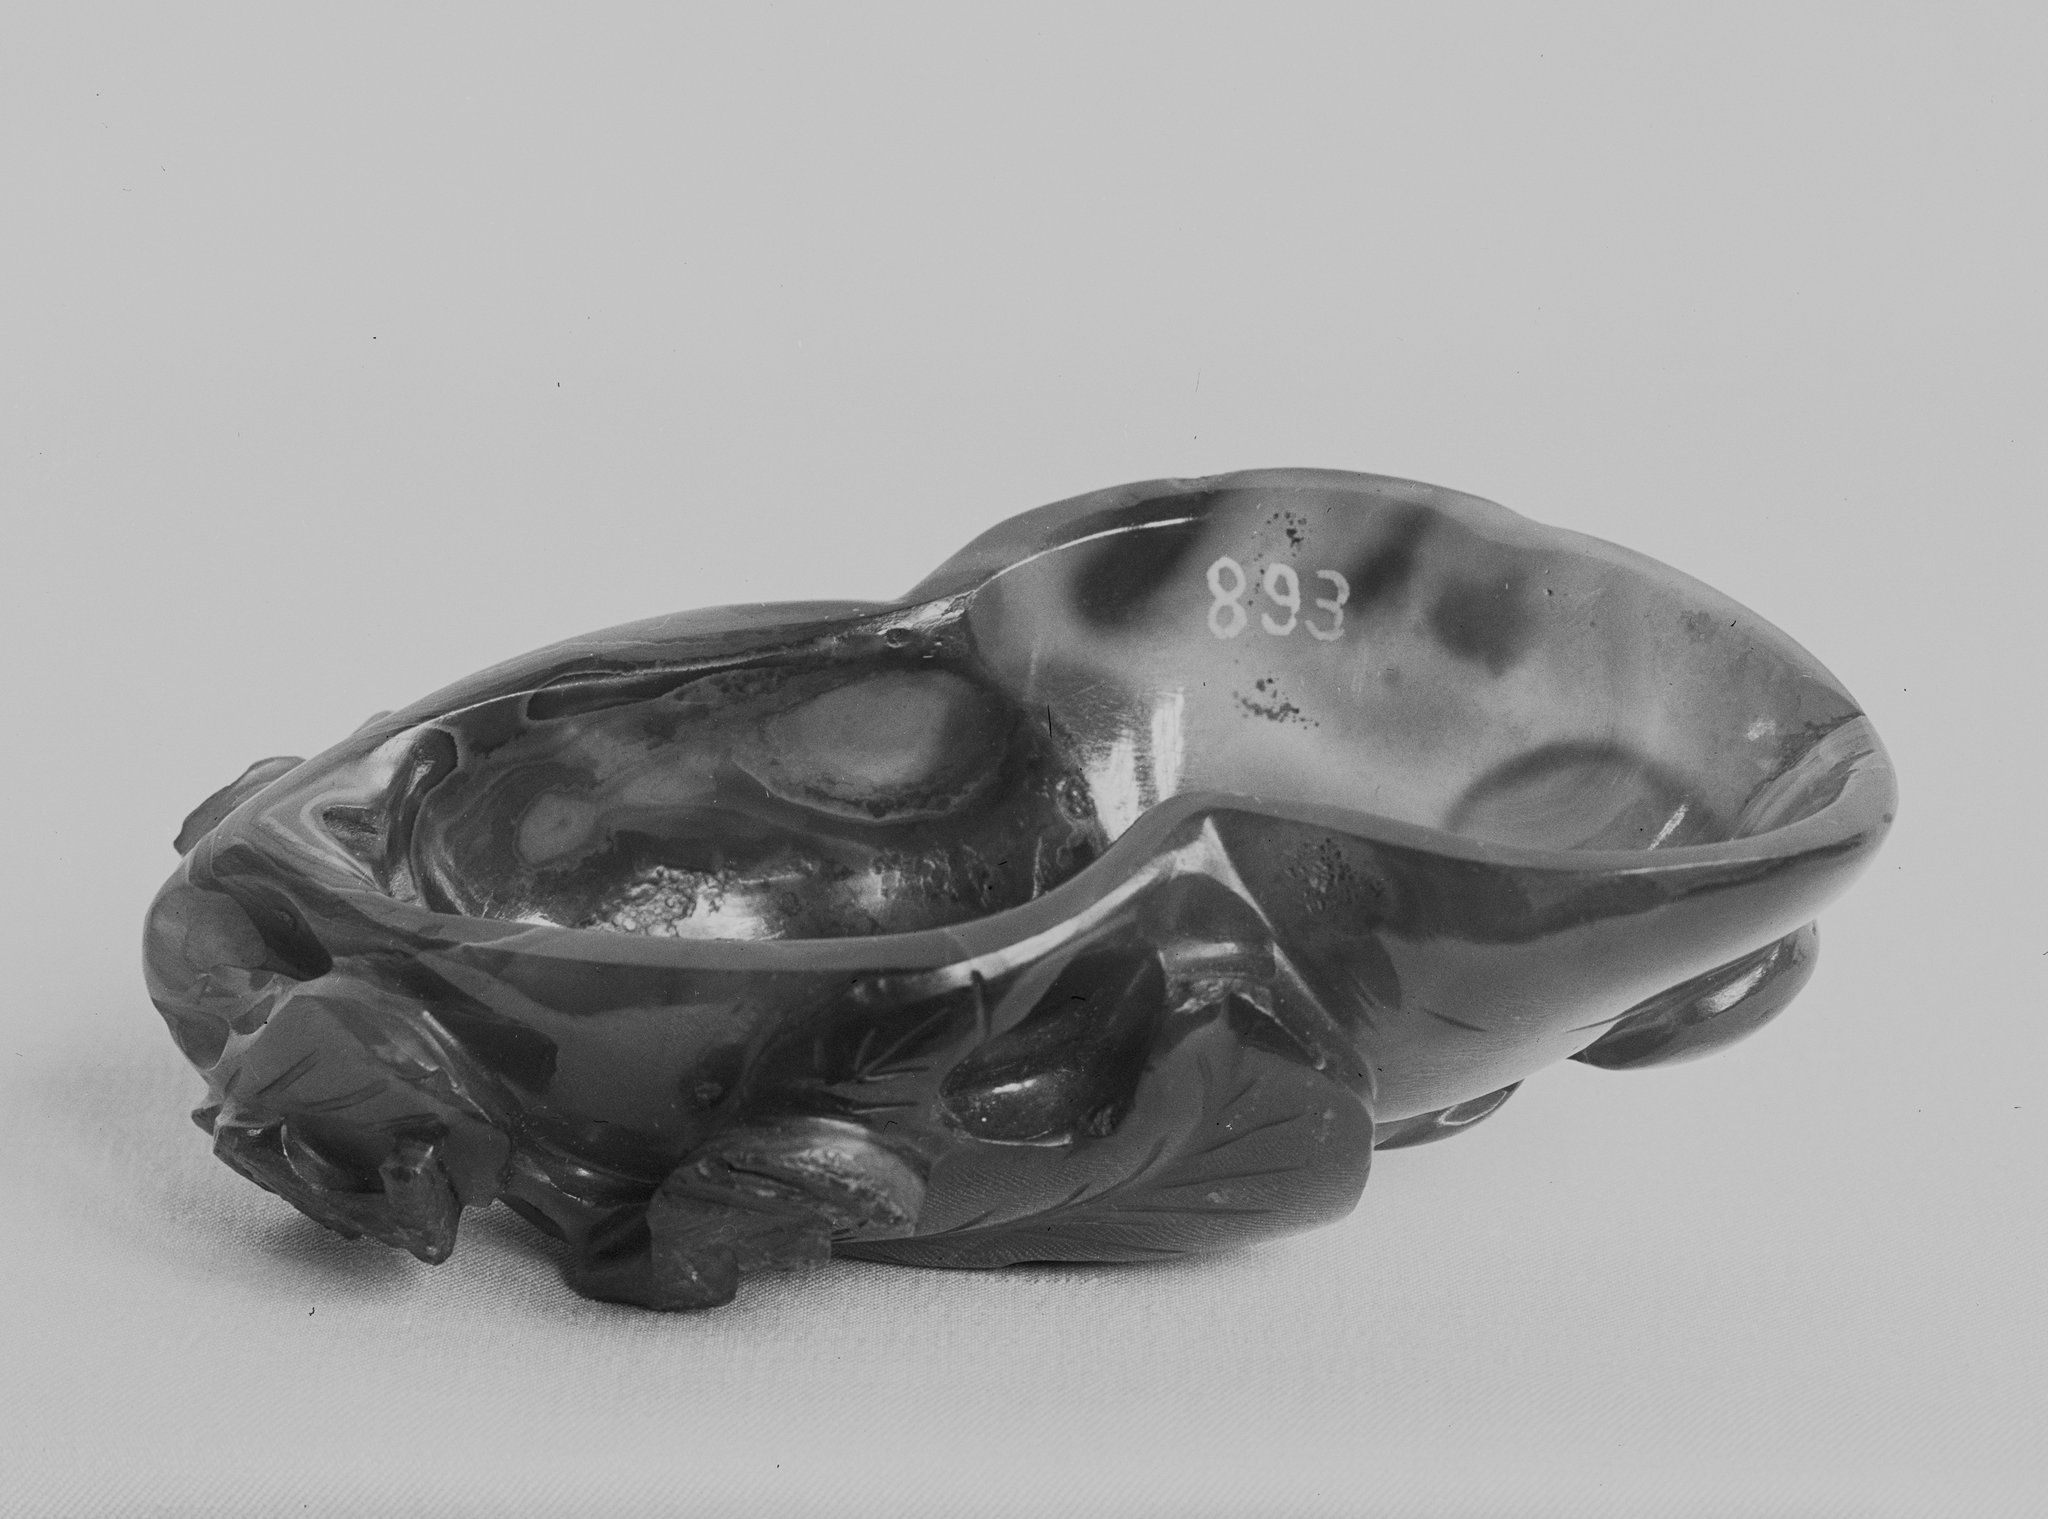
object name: dish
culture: chinese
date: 1701-1800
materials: stone